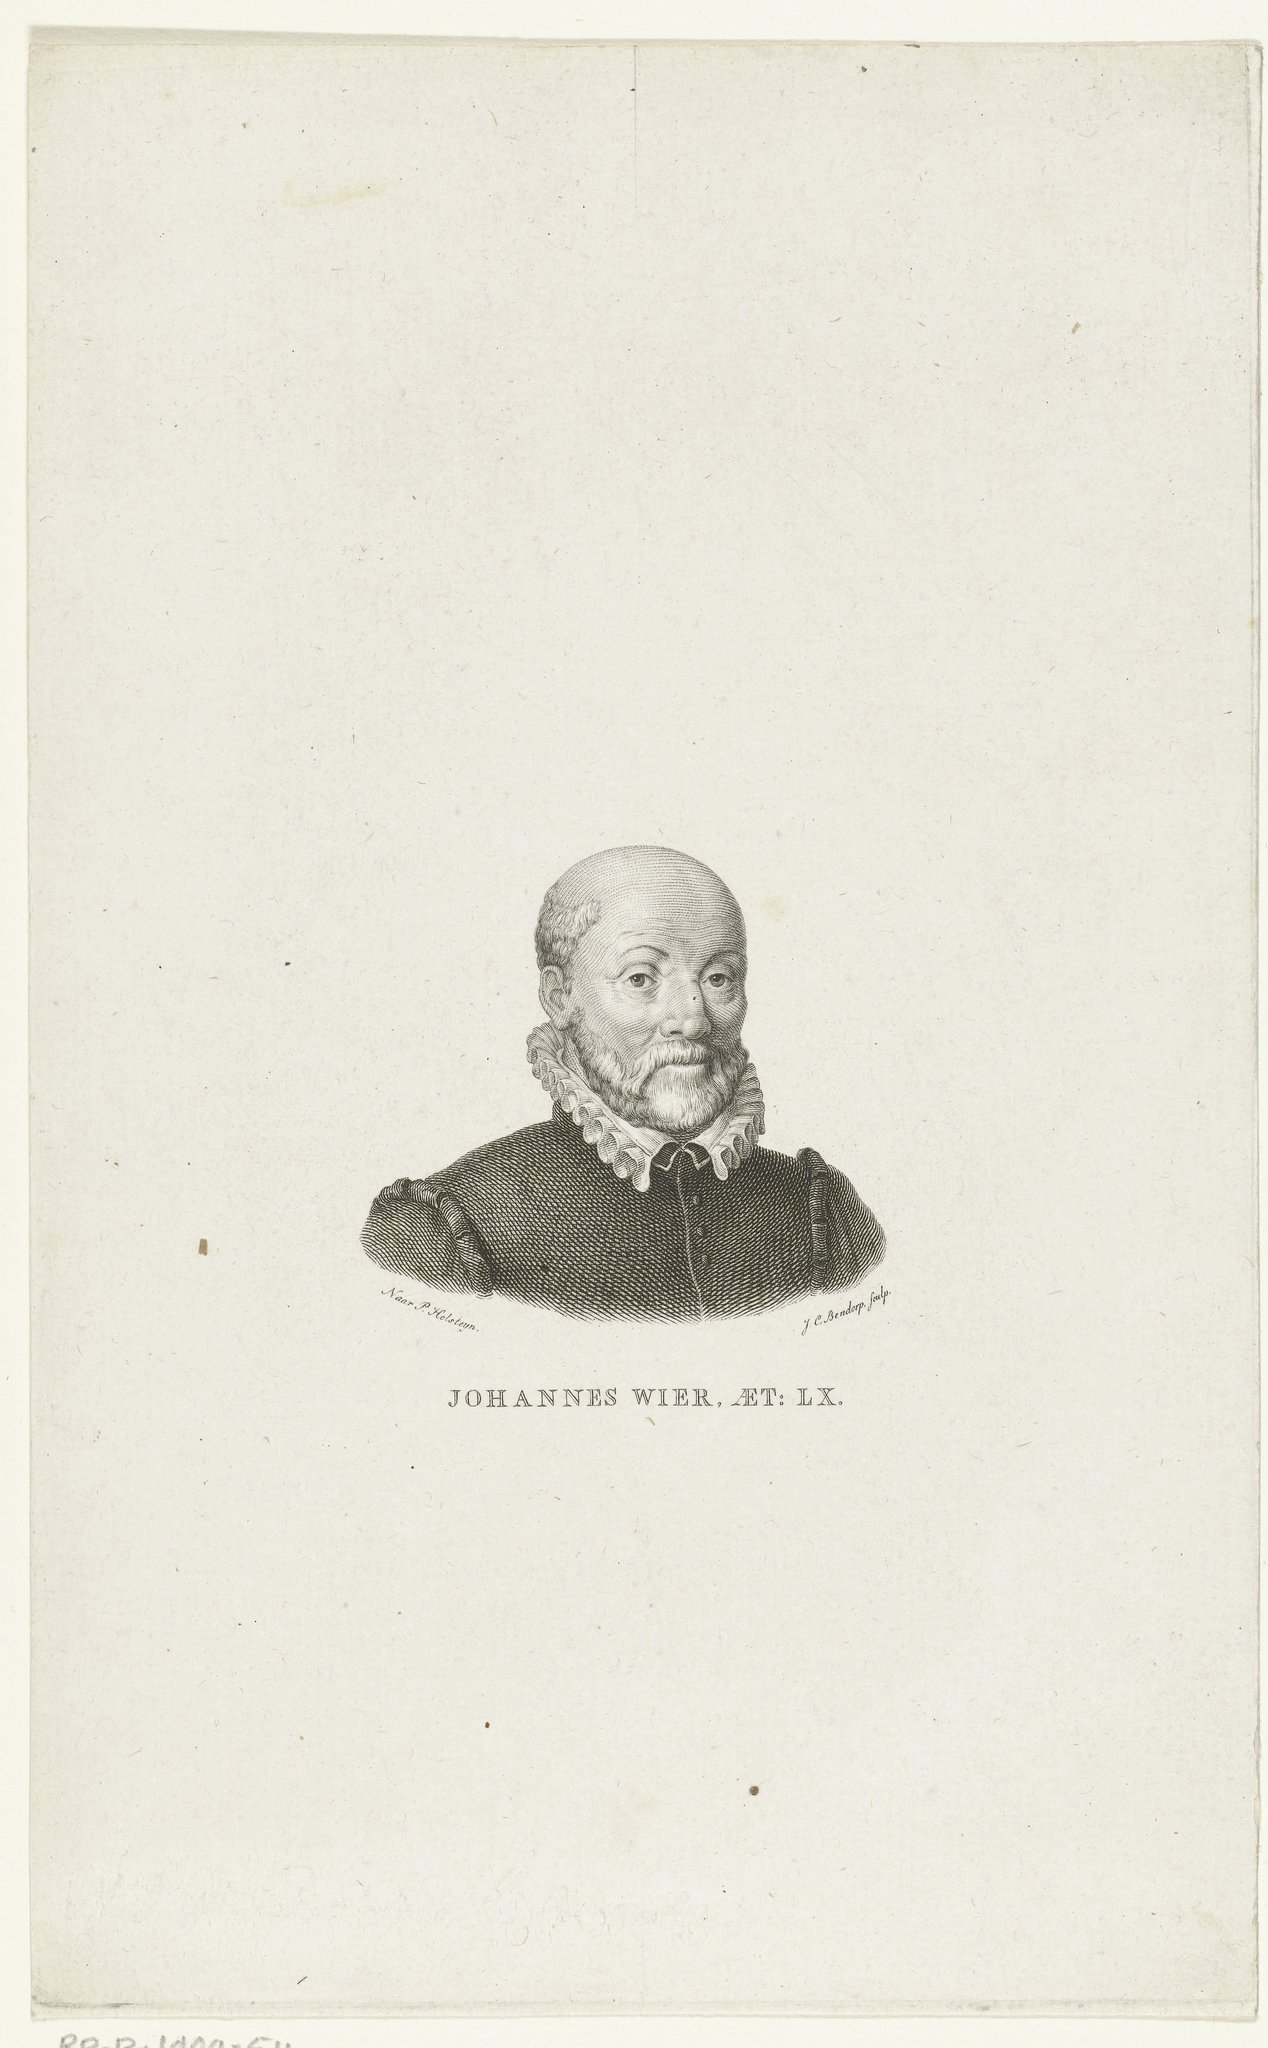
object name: print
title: Portret van arts Joannes Wier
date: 1776-1849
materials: paper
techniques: engraving, etching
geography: netherlands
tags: grave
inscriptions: collector's mark: Lugt 2228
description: Portret van arts Johannes Wier op zestigjarige leeftijd.